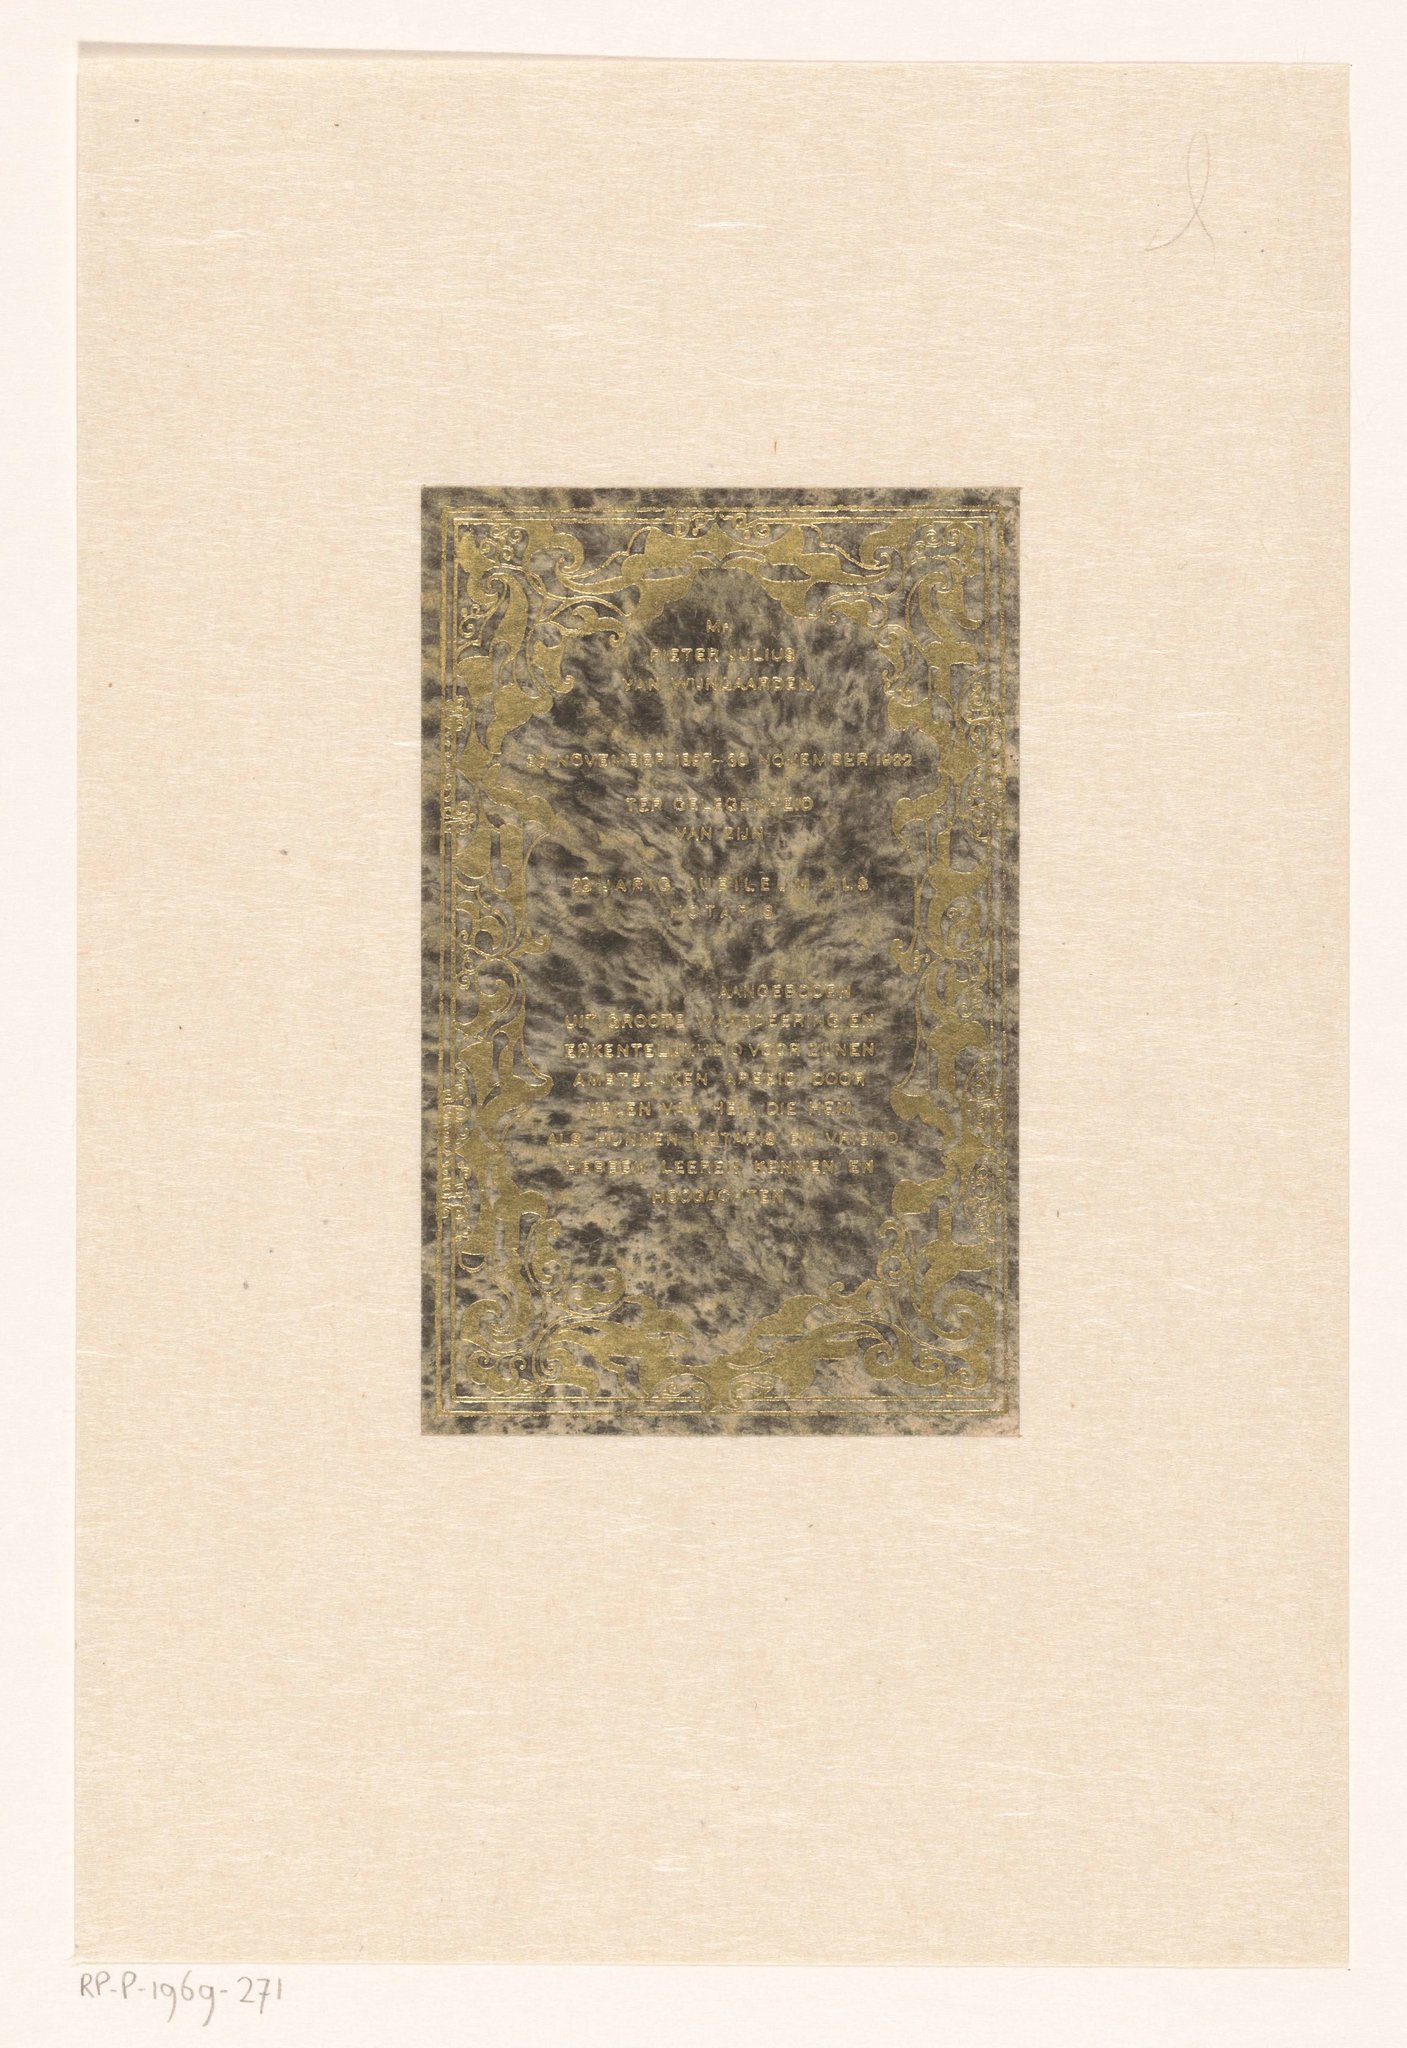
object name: print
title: Huldeblijk aan Mr. Pieter Julius van Wijngaarden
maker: carel adolph lion cachet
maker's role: draughtsman, print maker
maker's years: 1864-1945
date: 1922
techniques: marbling, printing block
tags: p.j. van wijngaarden, ornament derived from plant forms - aa - stylized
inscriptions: collector's mark: Lugt 2228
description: Prent ter gelegenheid van het vijfentwintigjarig jubileum als notaris van Mr. P.J. van Wijngaarden.